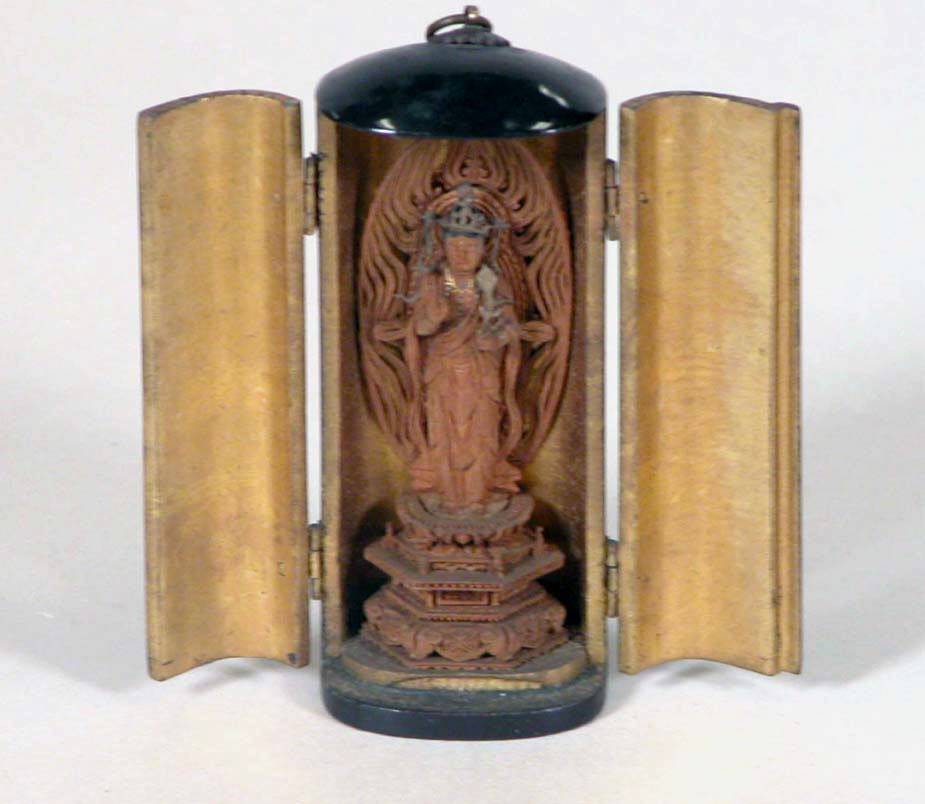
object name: traveller's shrine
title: Portable Shrine (zushi) with Shō Kannon, the Bodhisattva of Compassion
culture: japanese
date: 1801-1900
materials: bronze, gold, lacquer, wood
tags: buddhism,bodhisattvas